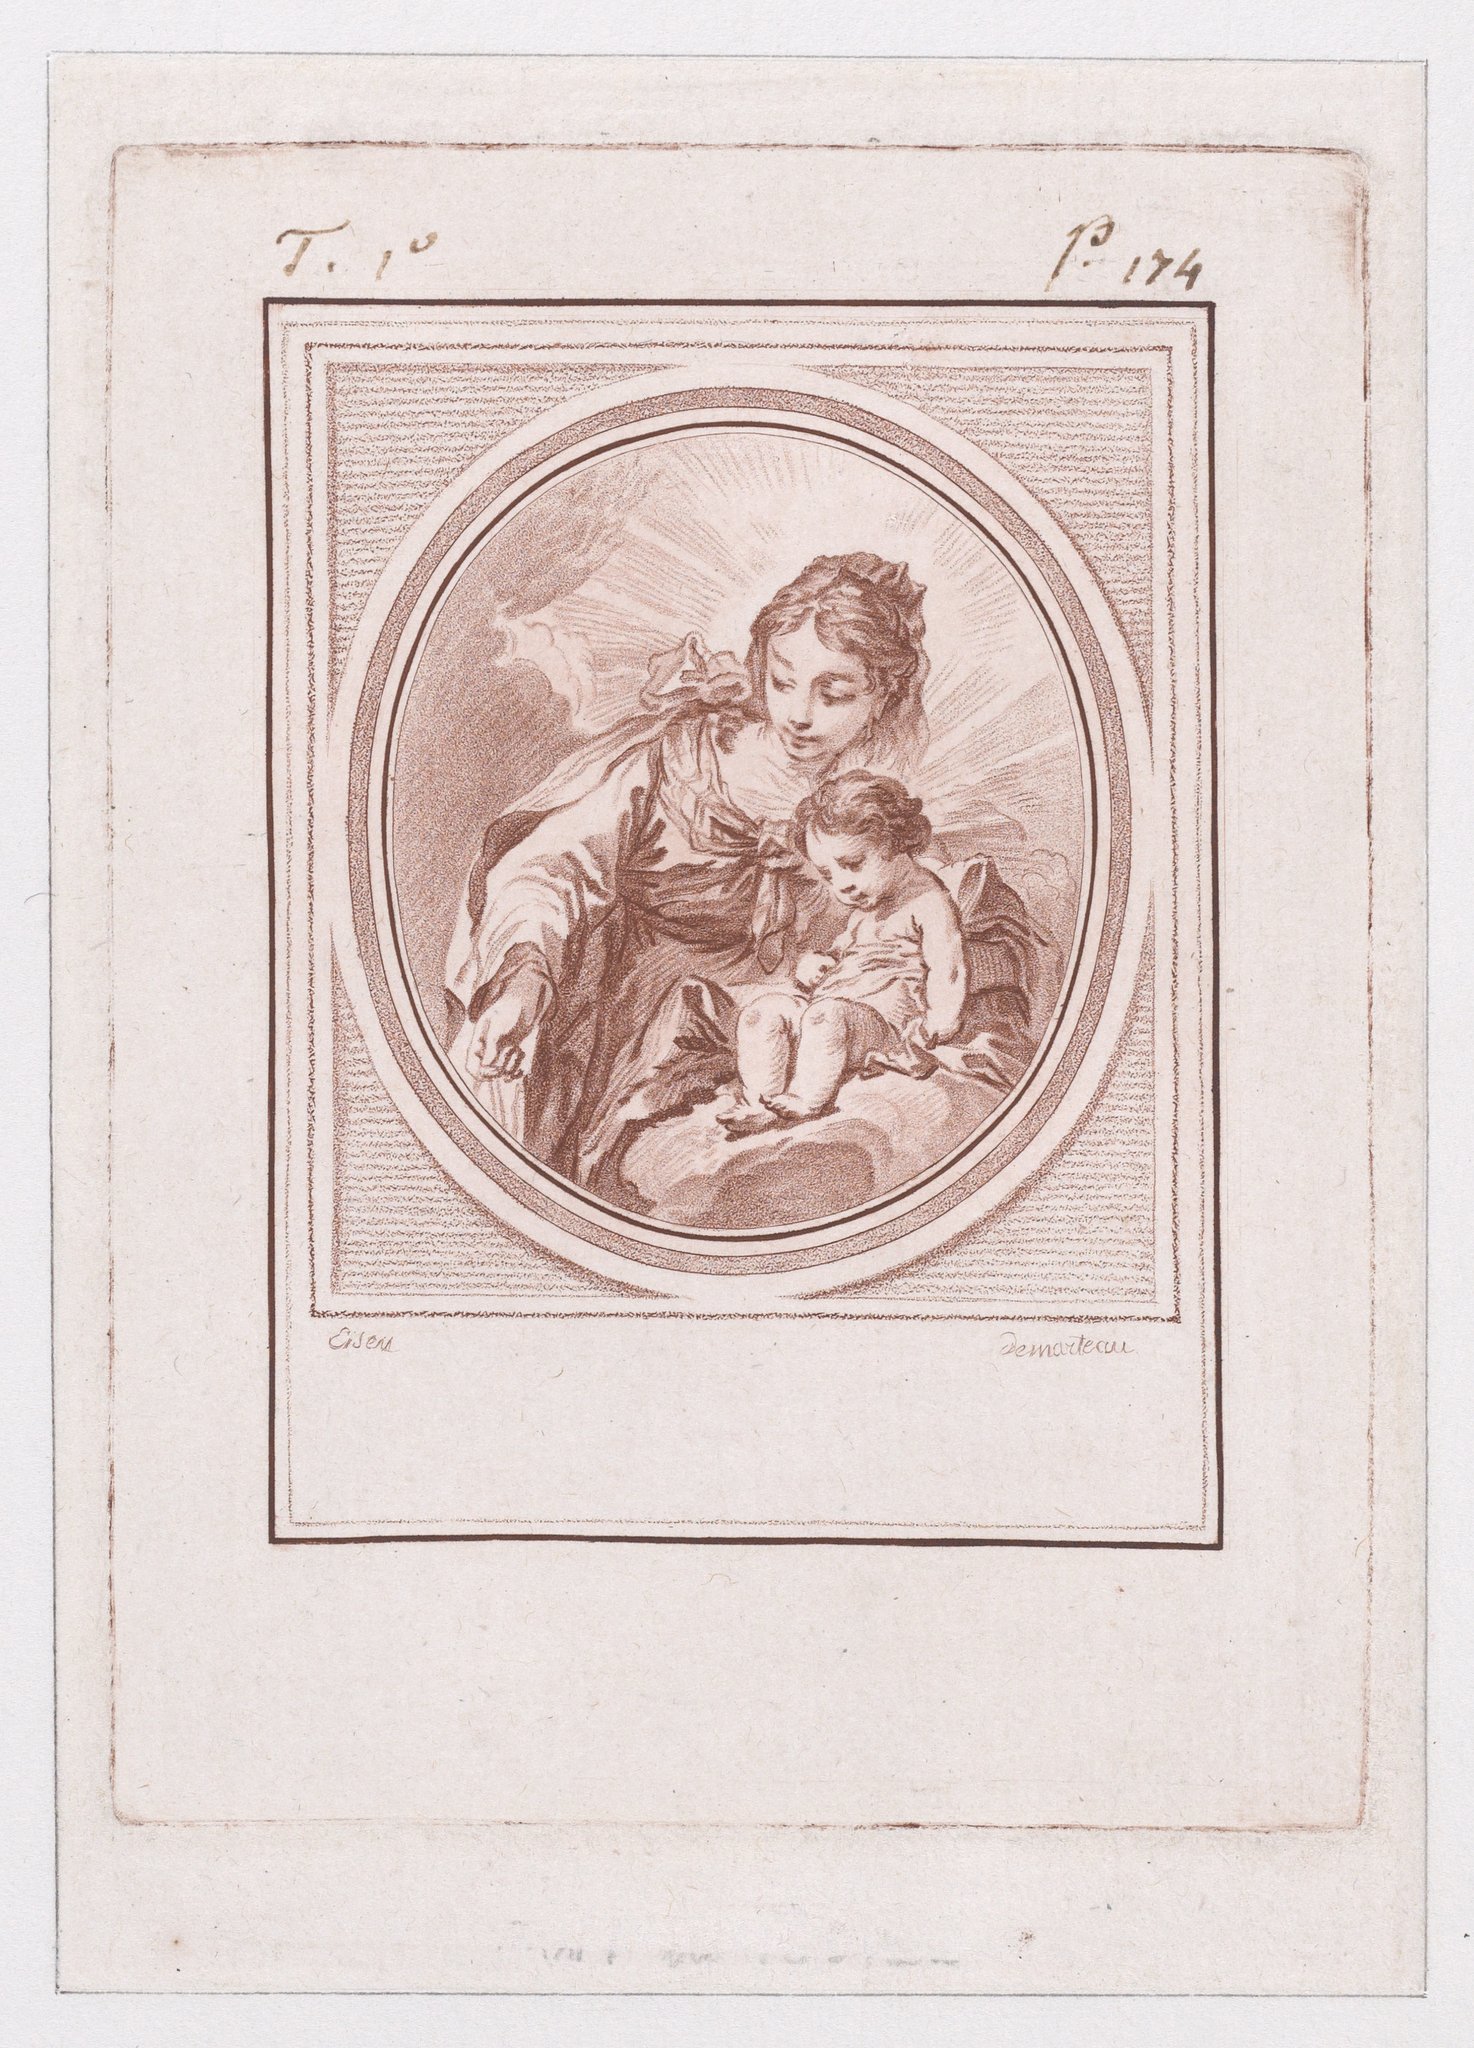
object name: print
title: Vierge, d'après Eisen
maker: gilles-antoine demarteau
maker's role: artist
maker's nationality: french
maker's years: 1756-1802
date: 1788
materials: ink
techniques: printmaking, etching, printing